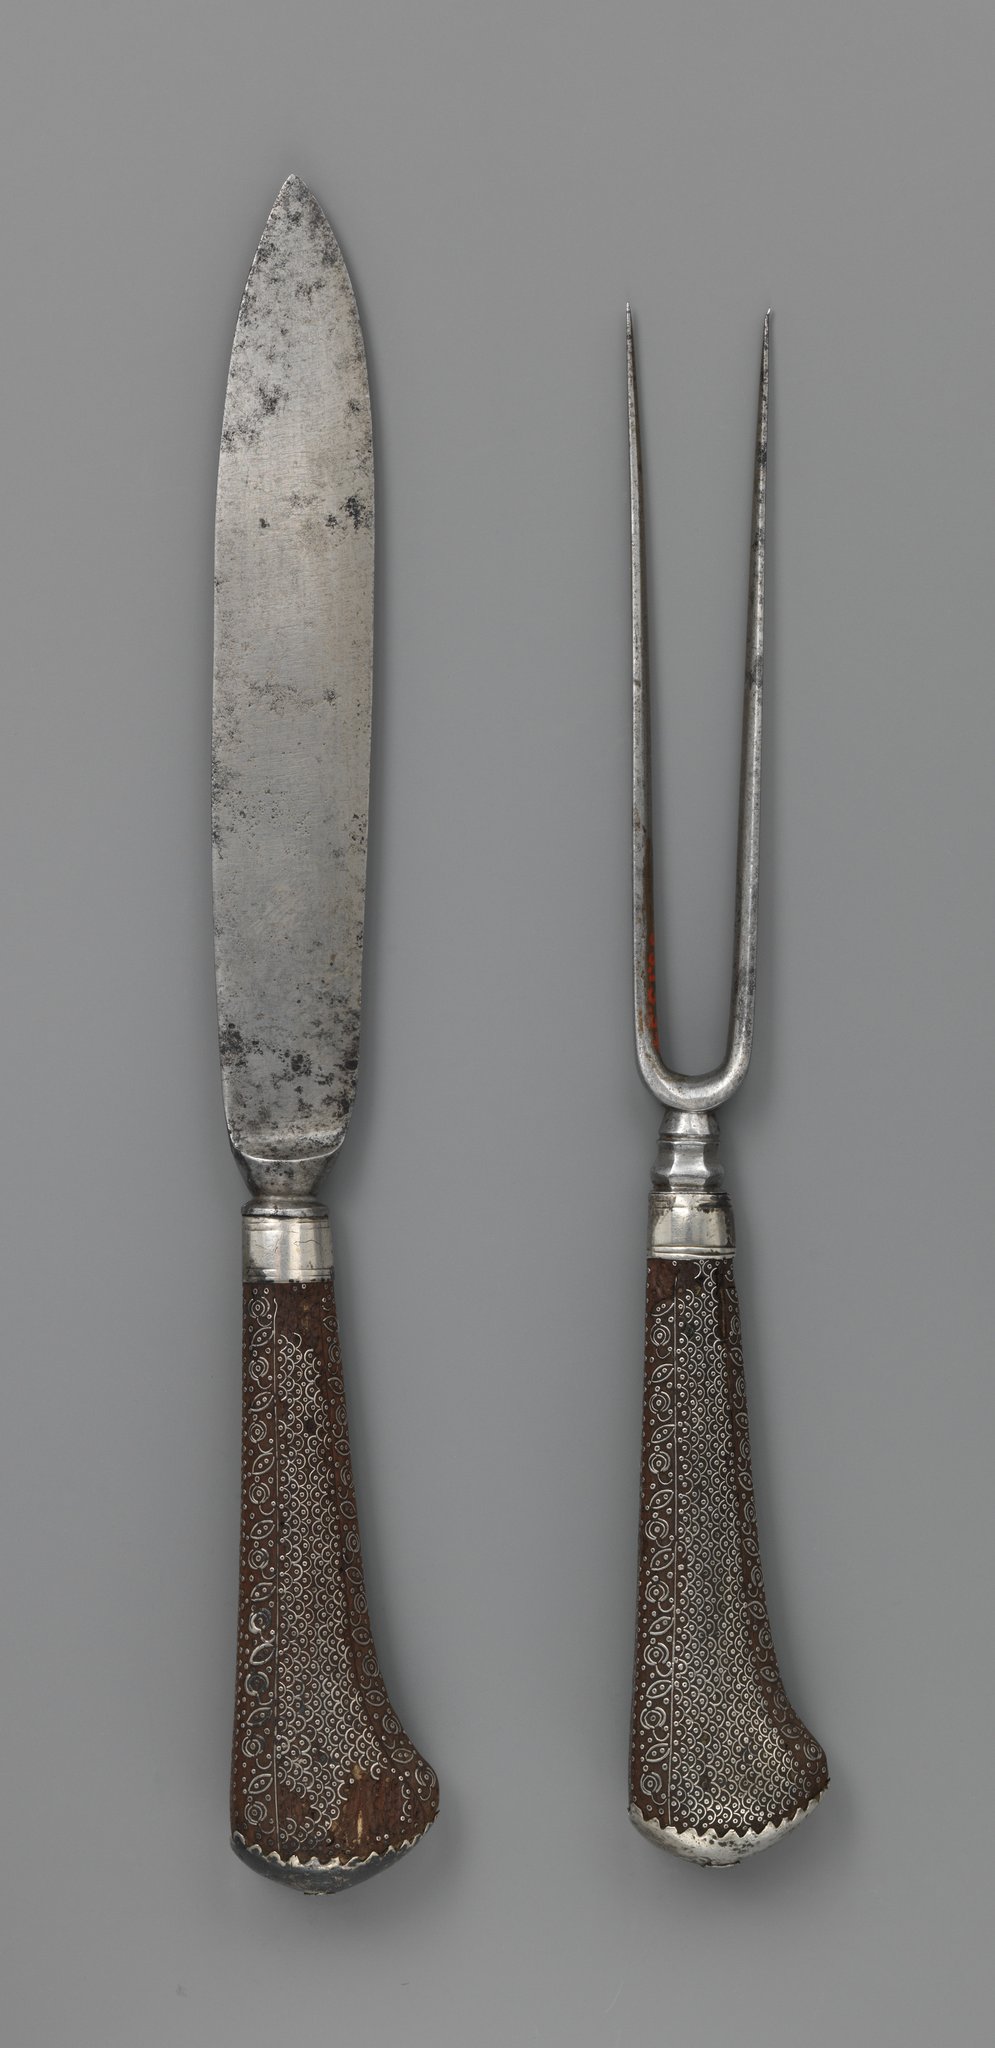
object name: knife and fork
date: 1601-1700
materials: steel